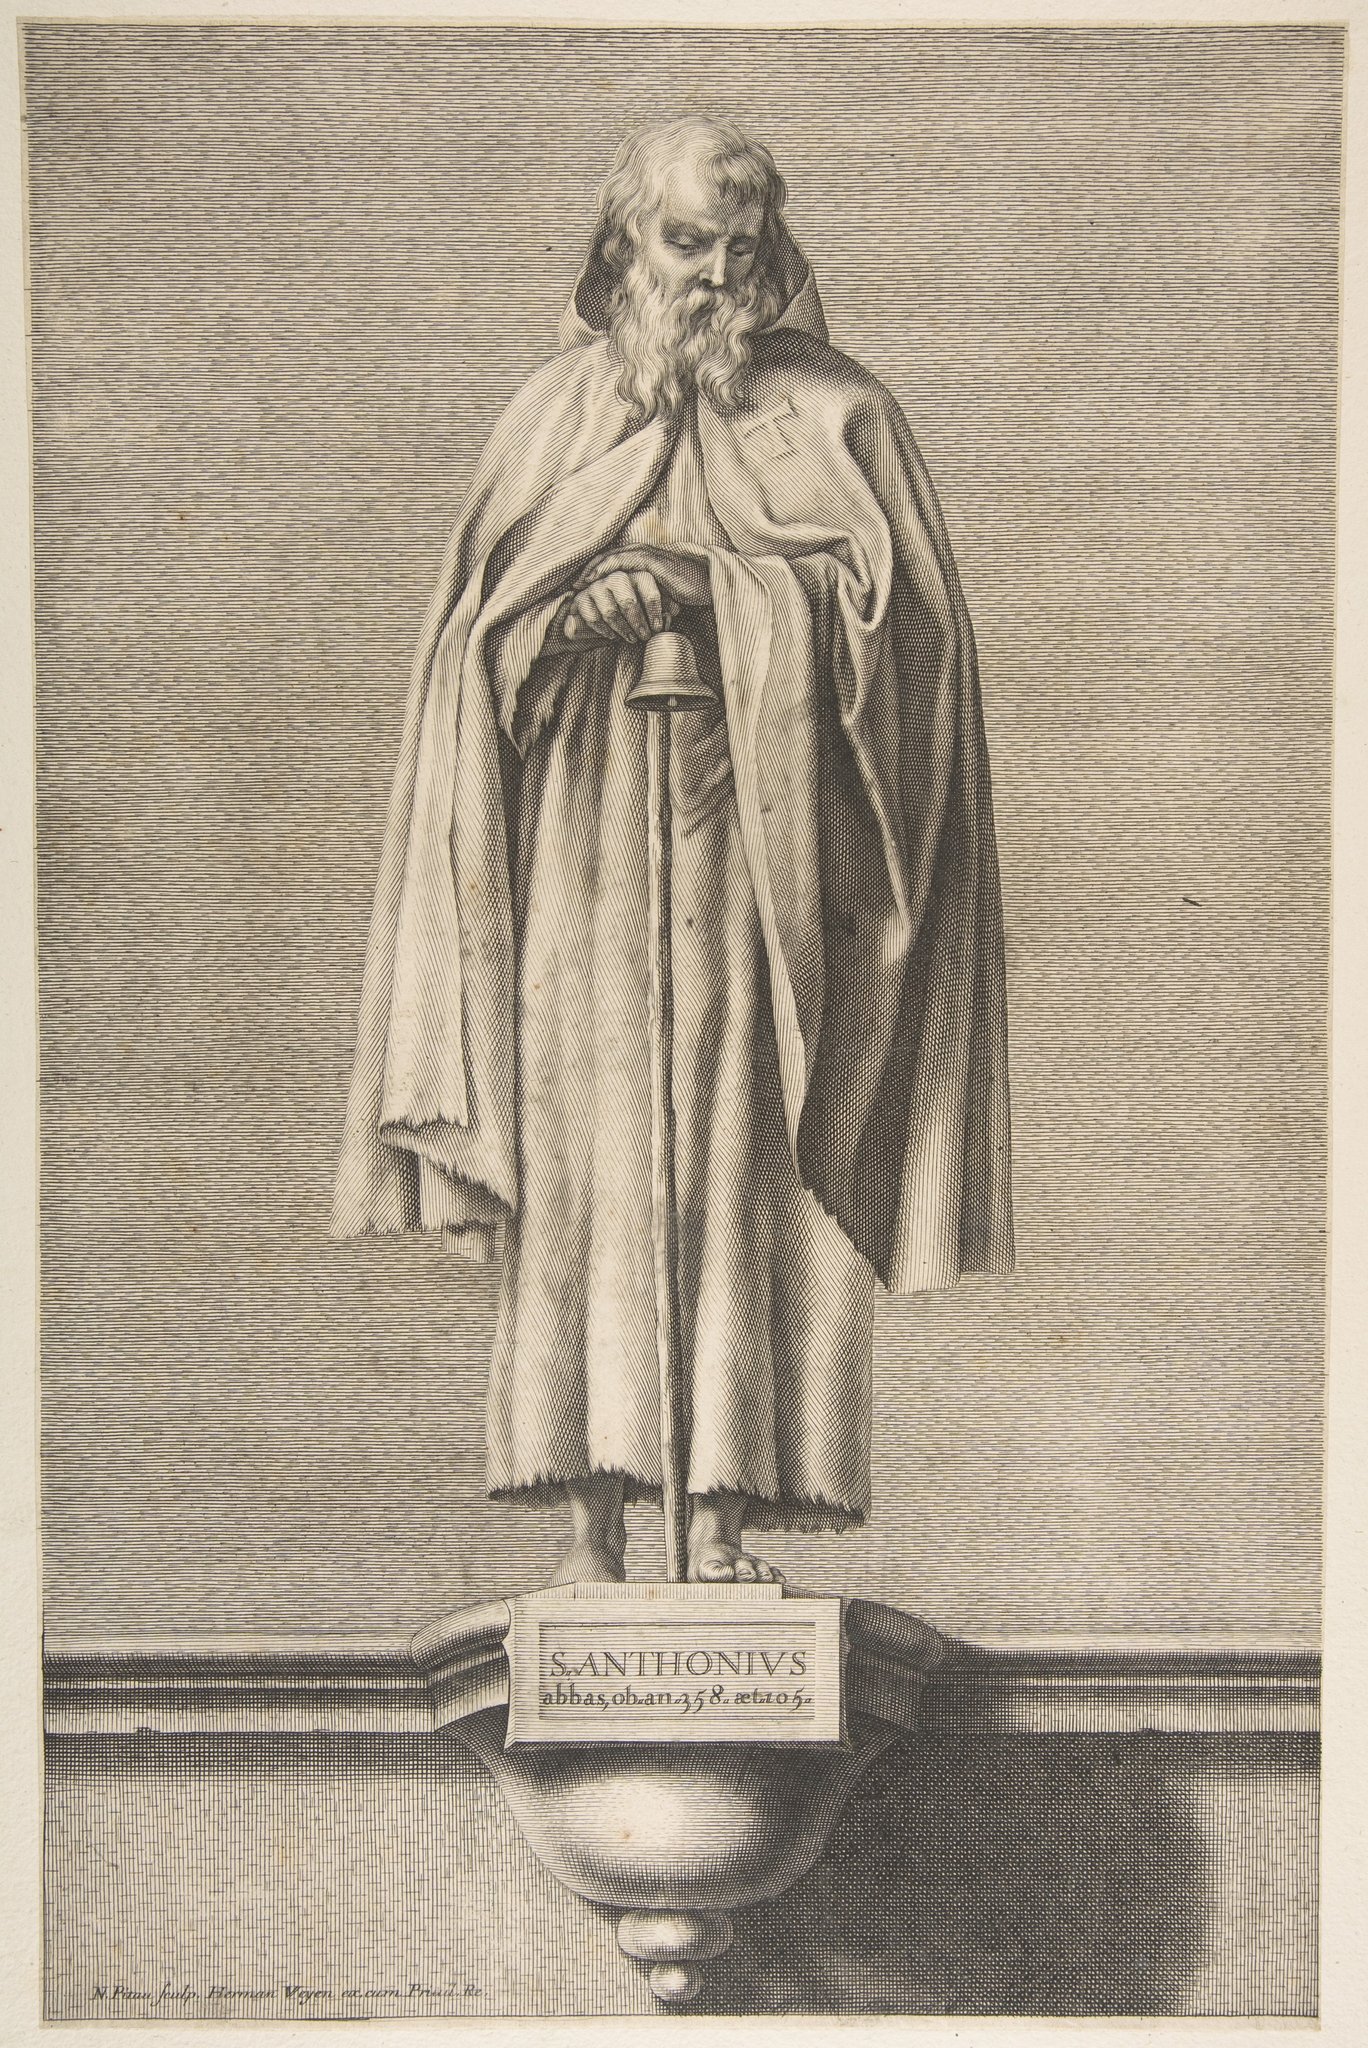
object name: print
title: St. Anthony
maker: nicolas pitau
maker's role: artist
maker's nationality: french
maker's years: 1670-1724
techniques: engraving, etching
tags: saint anthony